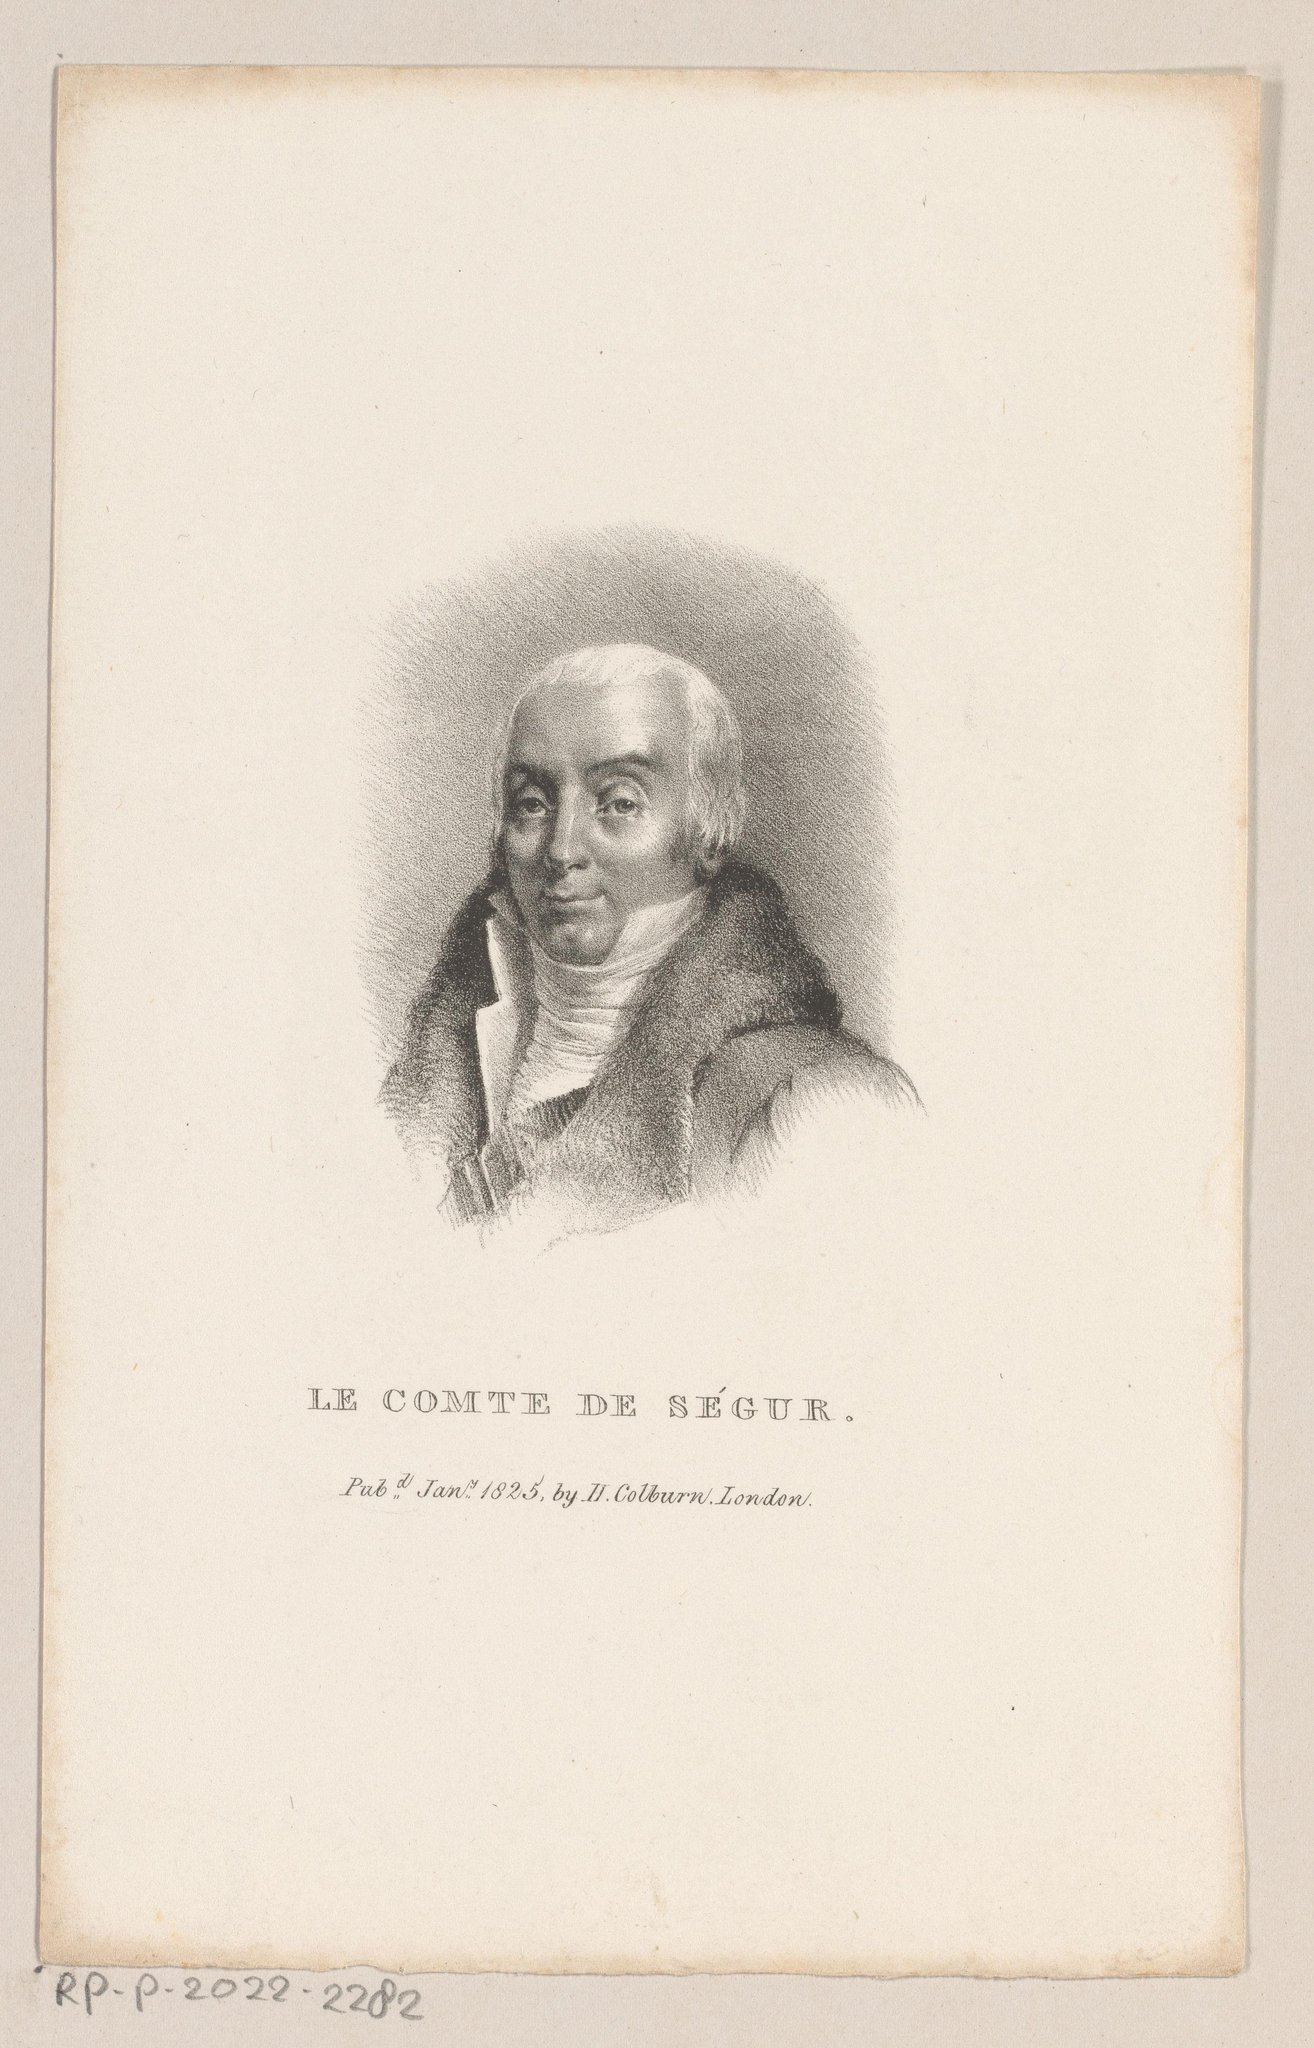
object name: print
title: Portret van Louis-Philippe de Ségur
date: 1801-1825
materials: paper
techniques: lithograph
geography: london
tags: paris, politician, history and archaeology (+ portrait of scholar, scientist), historical persons, diplomacy, diplomat